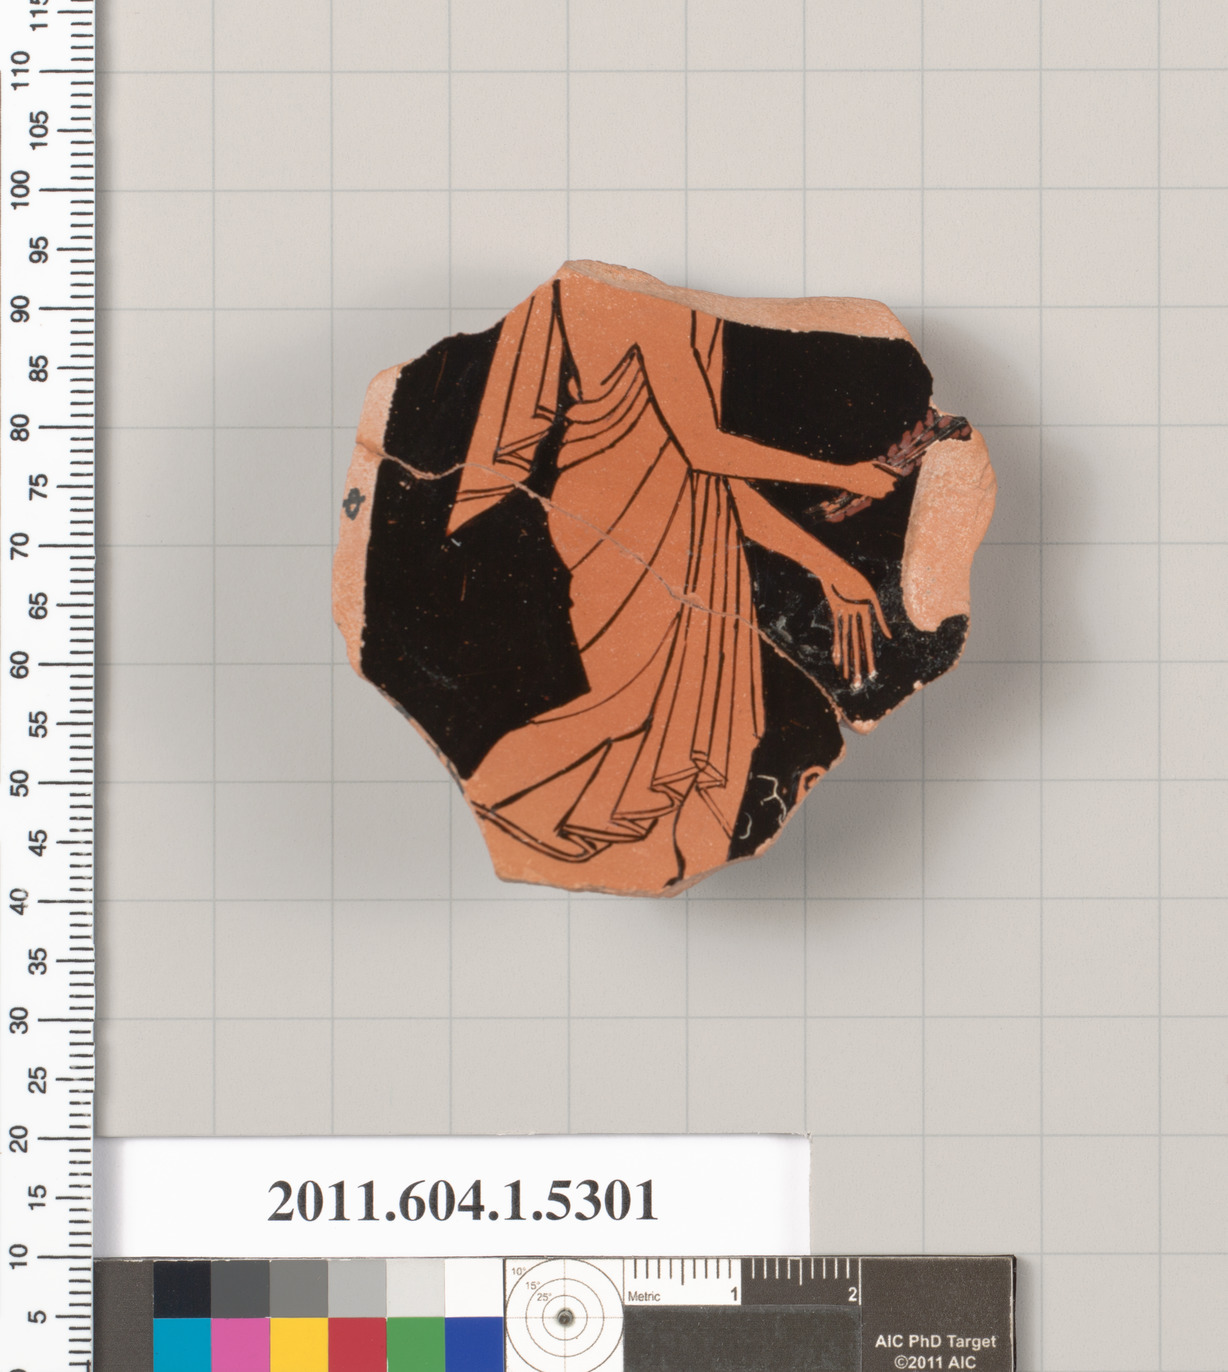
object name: kylix fragment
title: Terracotta fragment of a kylix (drinking cup)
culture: greek, attic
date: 534-468 BCE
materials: terracotta